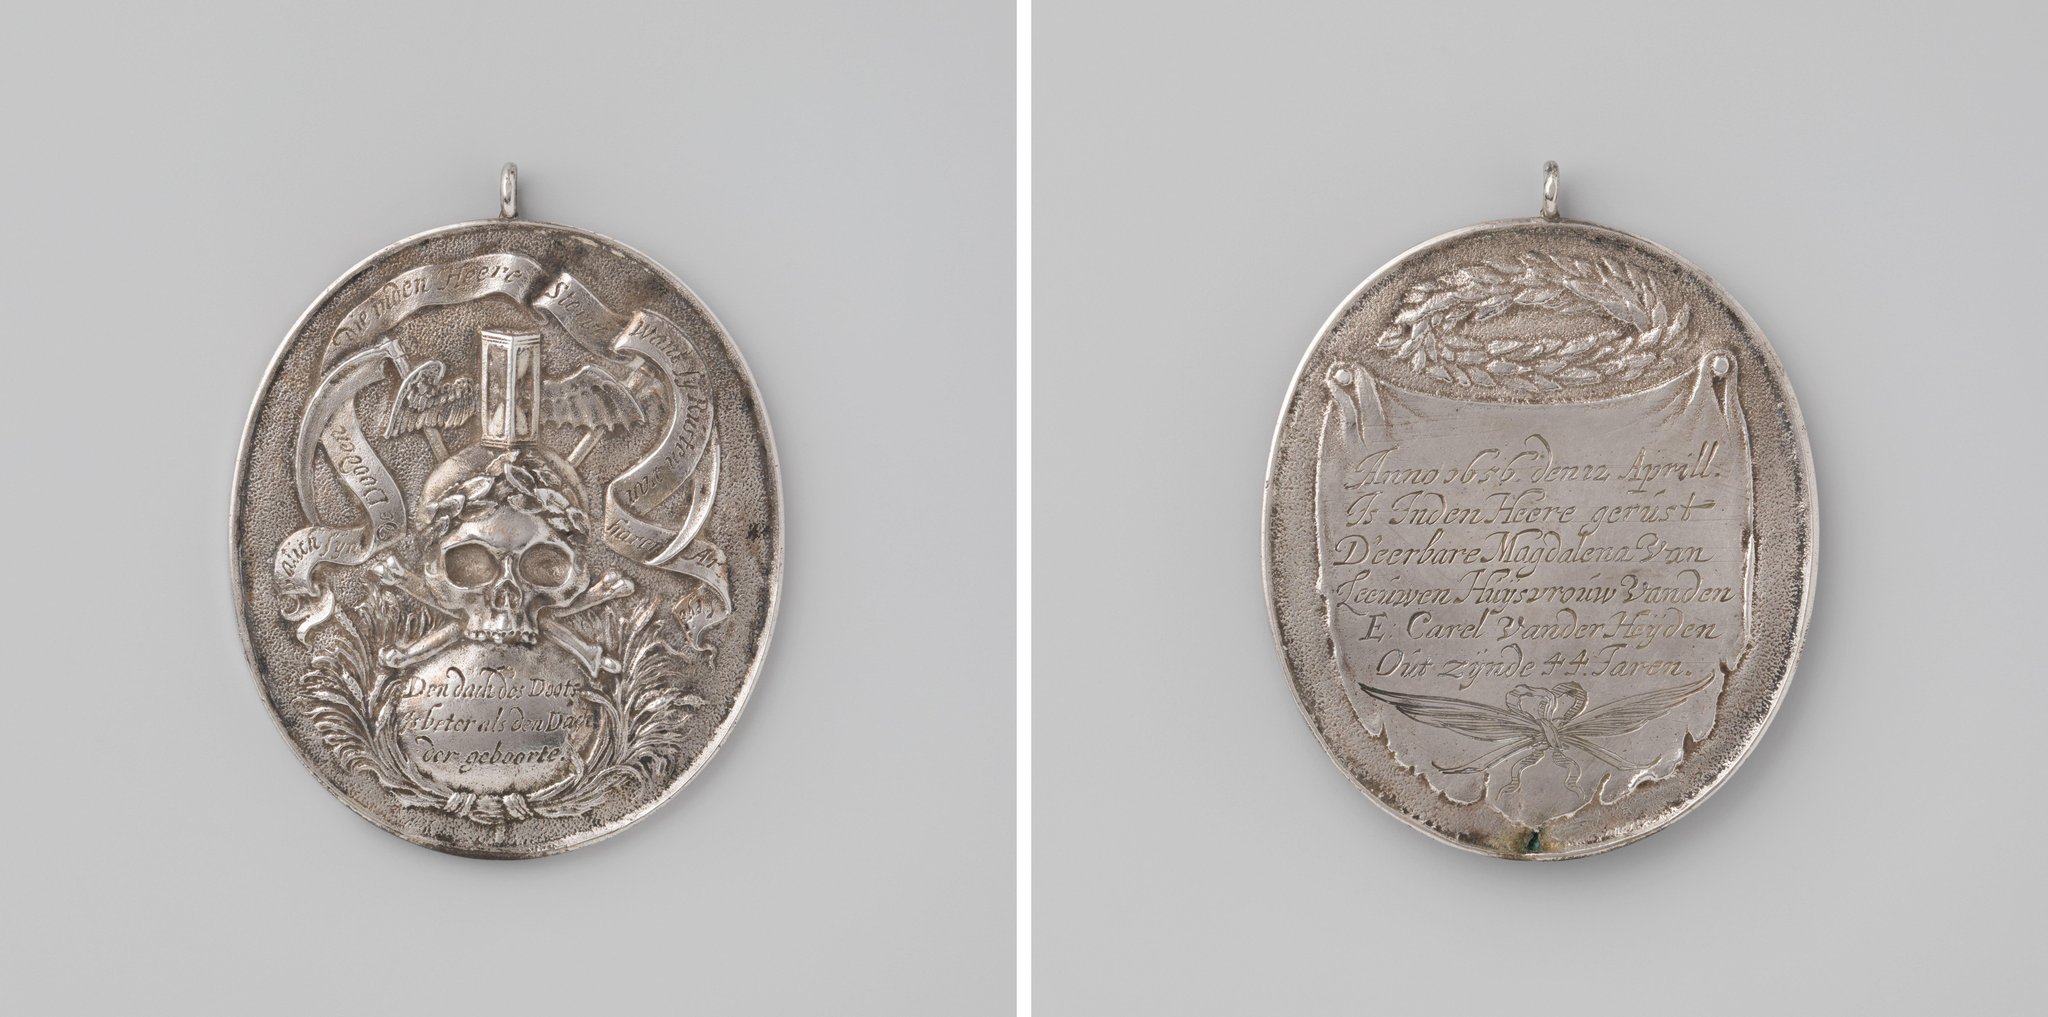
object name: insignia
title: Overlijden van Magdalena van Leeuwen, huisvrouw van Carel van der Heijden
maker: pieter van abeele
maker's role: draughtsman, jeweler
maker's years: 1608-1684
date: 1656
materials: silver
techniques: casting, engraving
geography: amsterdam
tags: magdalena van leeuwen, carel van der heijden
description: Zilveren ovale penning. Voorzijde: boven een omkranst doodshoofd een gevleugelde zandloper en twee zeisen met verschillende opschriften. Keerzijde: opschrift op een hangend doek onder een lauwerkrans